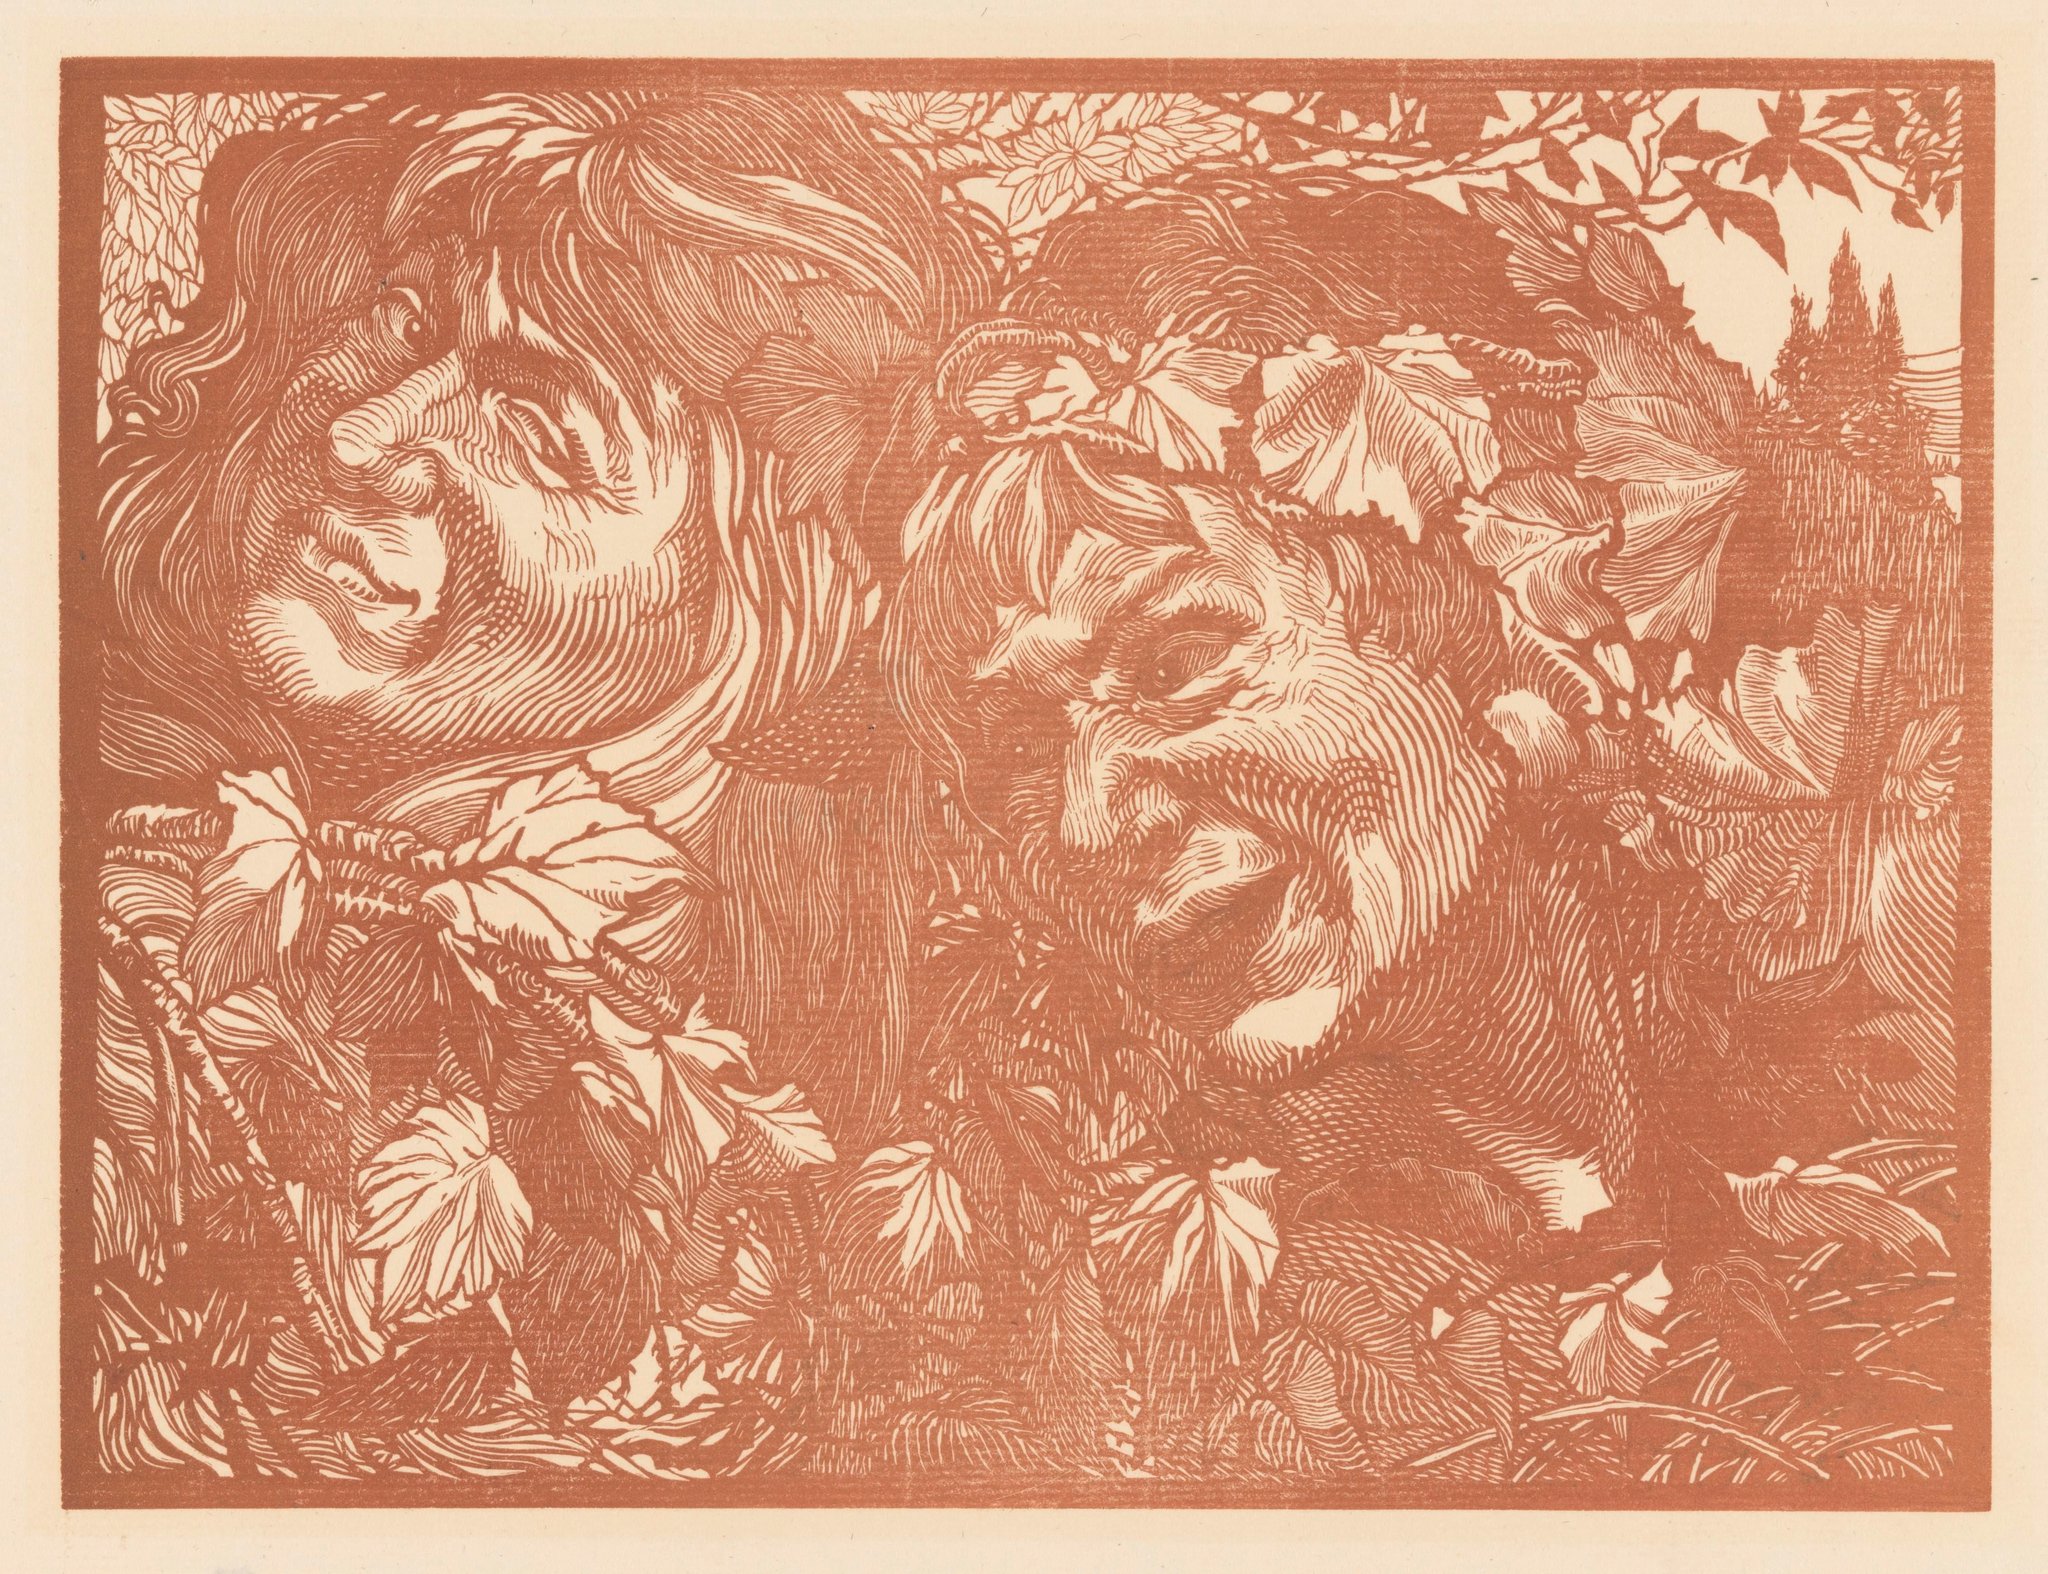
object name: print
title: Twee bacchanten omgeven door wingerdbladeren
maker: johannes josephus aarts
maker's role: draughtsman, print maker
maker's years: 1871-1934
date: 1897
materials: paper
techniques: woodcut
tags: maenad(s), female bacchant(es)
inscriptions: collector's mark: Lugt 2166, collector's mark: Lugt 2760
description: Twee bacchanten of maenaden, vrouwelijke vereerders van de vruchtbaarheidsgod Bacchus. Ze zijn omgeven door wingerdbladeren. Een van hen draagt een krans.